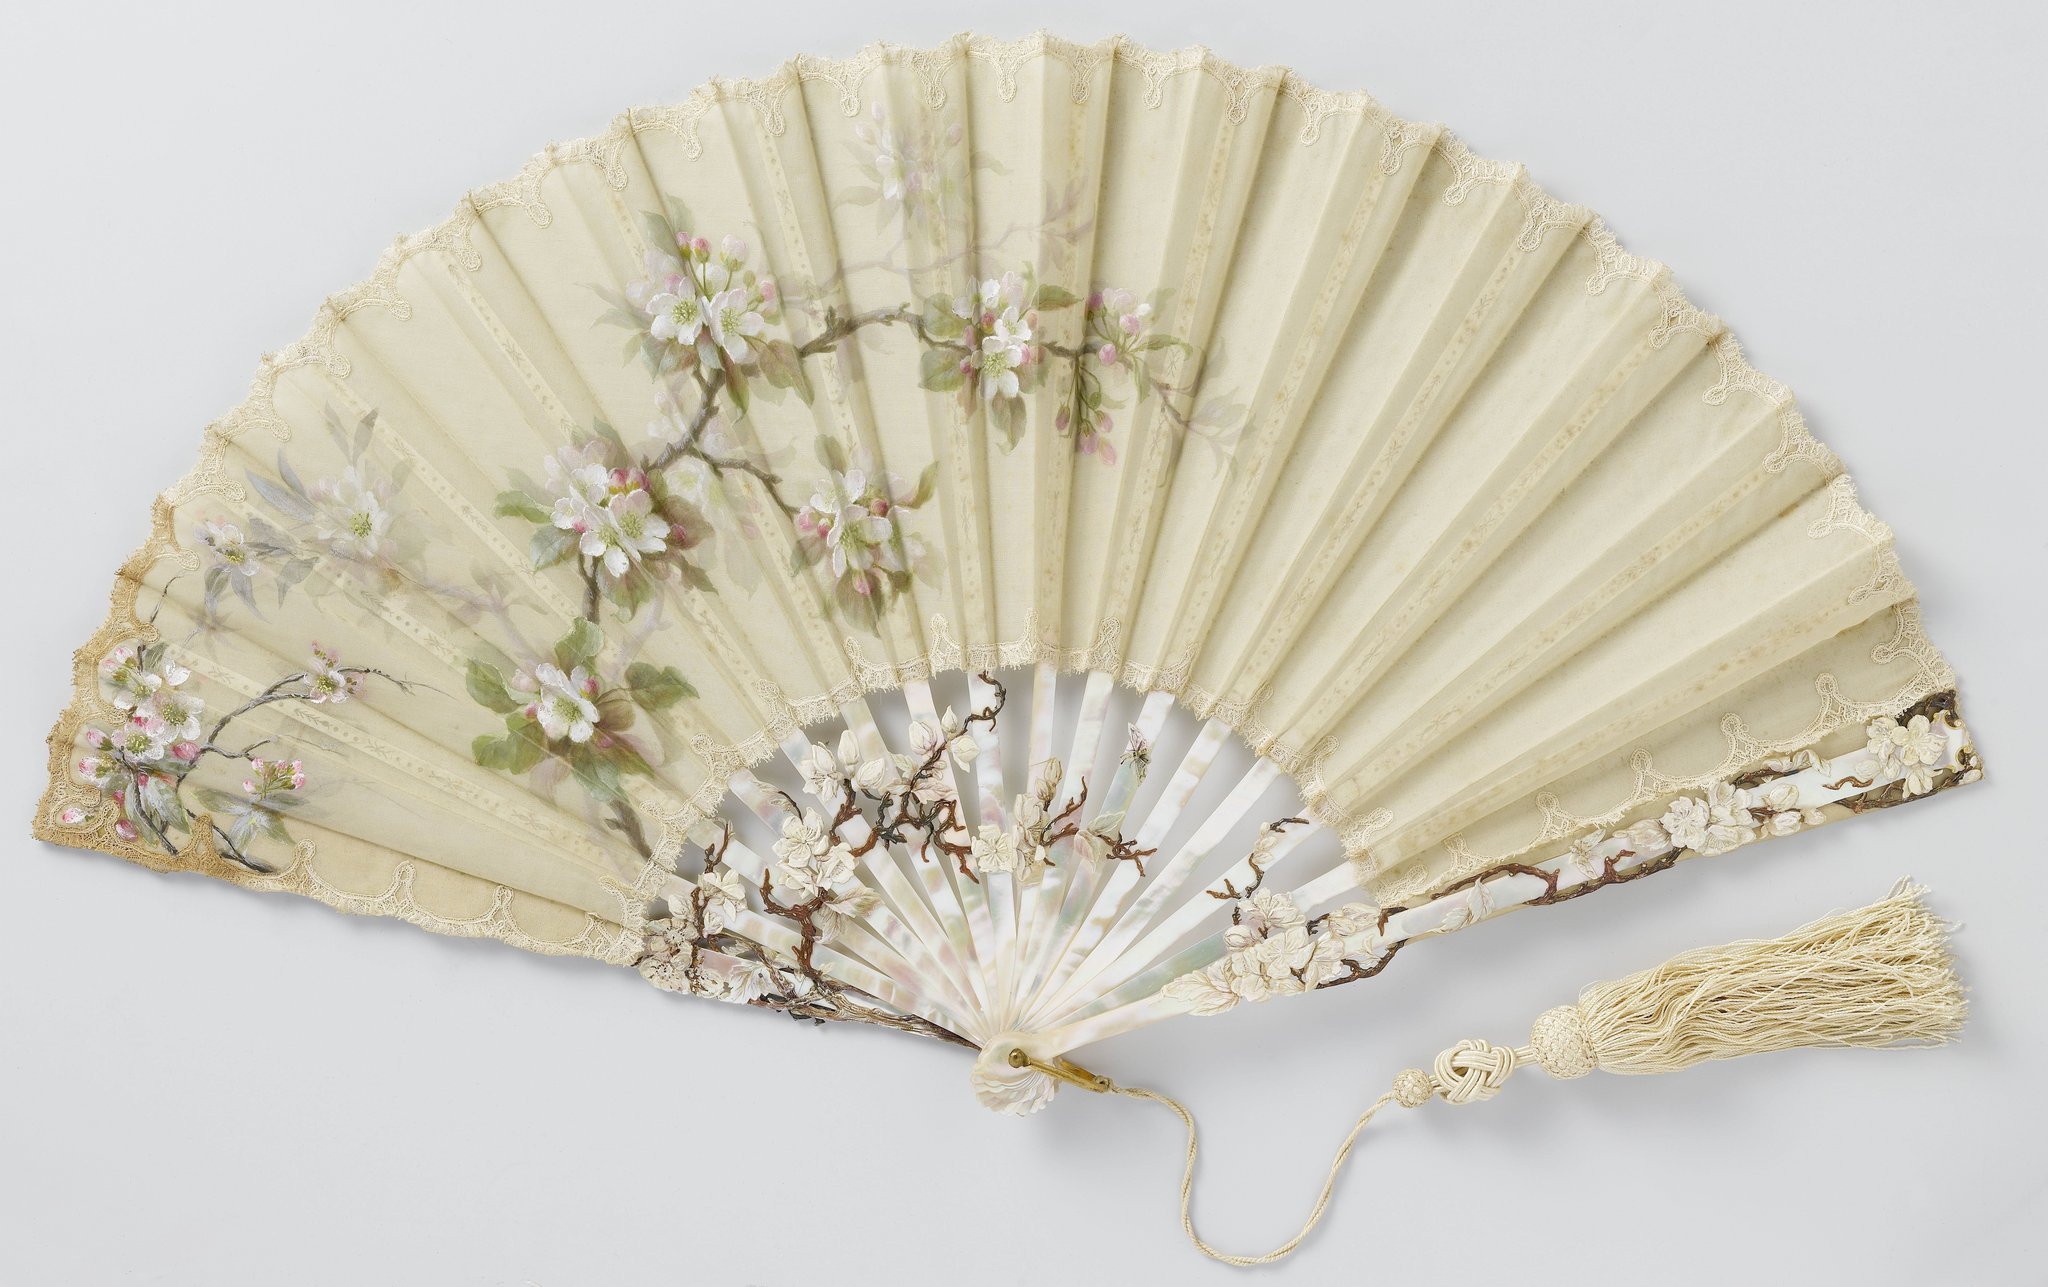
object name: vouwwaaier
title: Vouwwaaier met dubbel blad van batist waarop met gouache takken appelbloesem zijn geschilderd, op een montuur van gesneden en gedeeltelijk geschilderd parelmoer, voorzien van metalen (zilveren?) monogram M.S.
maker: weduwe w. van der hulst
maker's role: hofleverancier, winkelier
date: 1890-1899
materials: textile, bone, cardboard, copper, gouache, mother of pearl, oil, silk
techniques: lace, casting, cutting, knotting, painted, weave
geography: kalverstraat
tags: amsterdam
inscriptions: monogram: ‘M.S.’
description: Vouwwaaier (a) met dubbel blad batist, langs de uiteinden geschulpt en afgezet met kloskant. Asymmetrisch beschilderd met een grote en een kleine tak met appelbloesems. Montuur van parelmoer met 16 benen, waarvan de sluitbenen geheel gesneden en geverfd zijn met meanderende magnoliatakken. Op het rechter sluitbeen een metalen (zilveren?) monogram 'M.S.'; de initialen van Maria Schölvinck-Romme. Op de overige benen is alleen het zichtbare deel onder het blad versierd. Koperen sluitpin en ring met zijden kwast aan knoop van zijden draad.